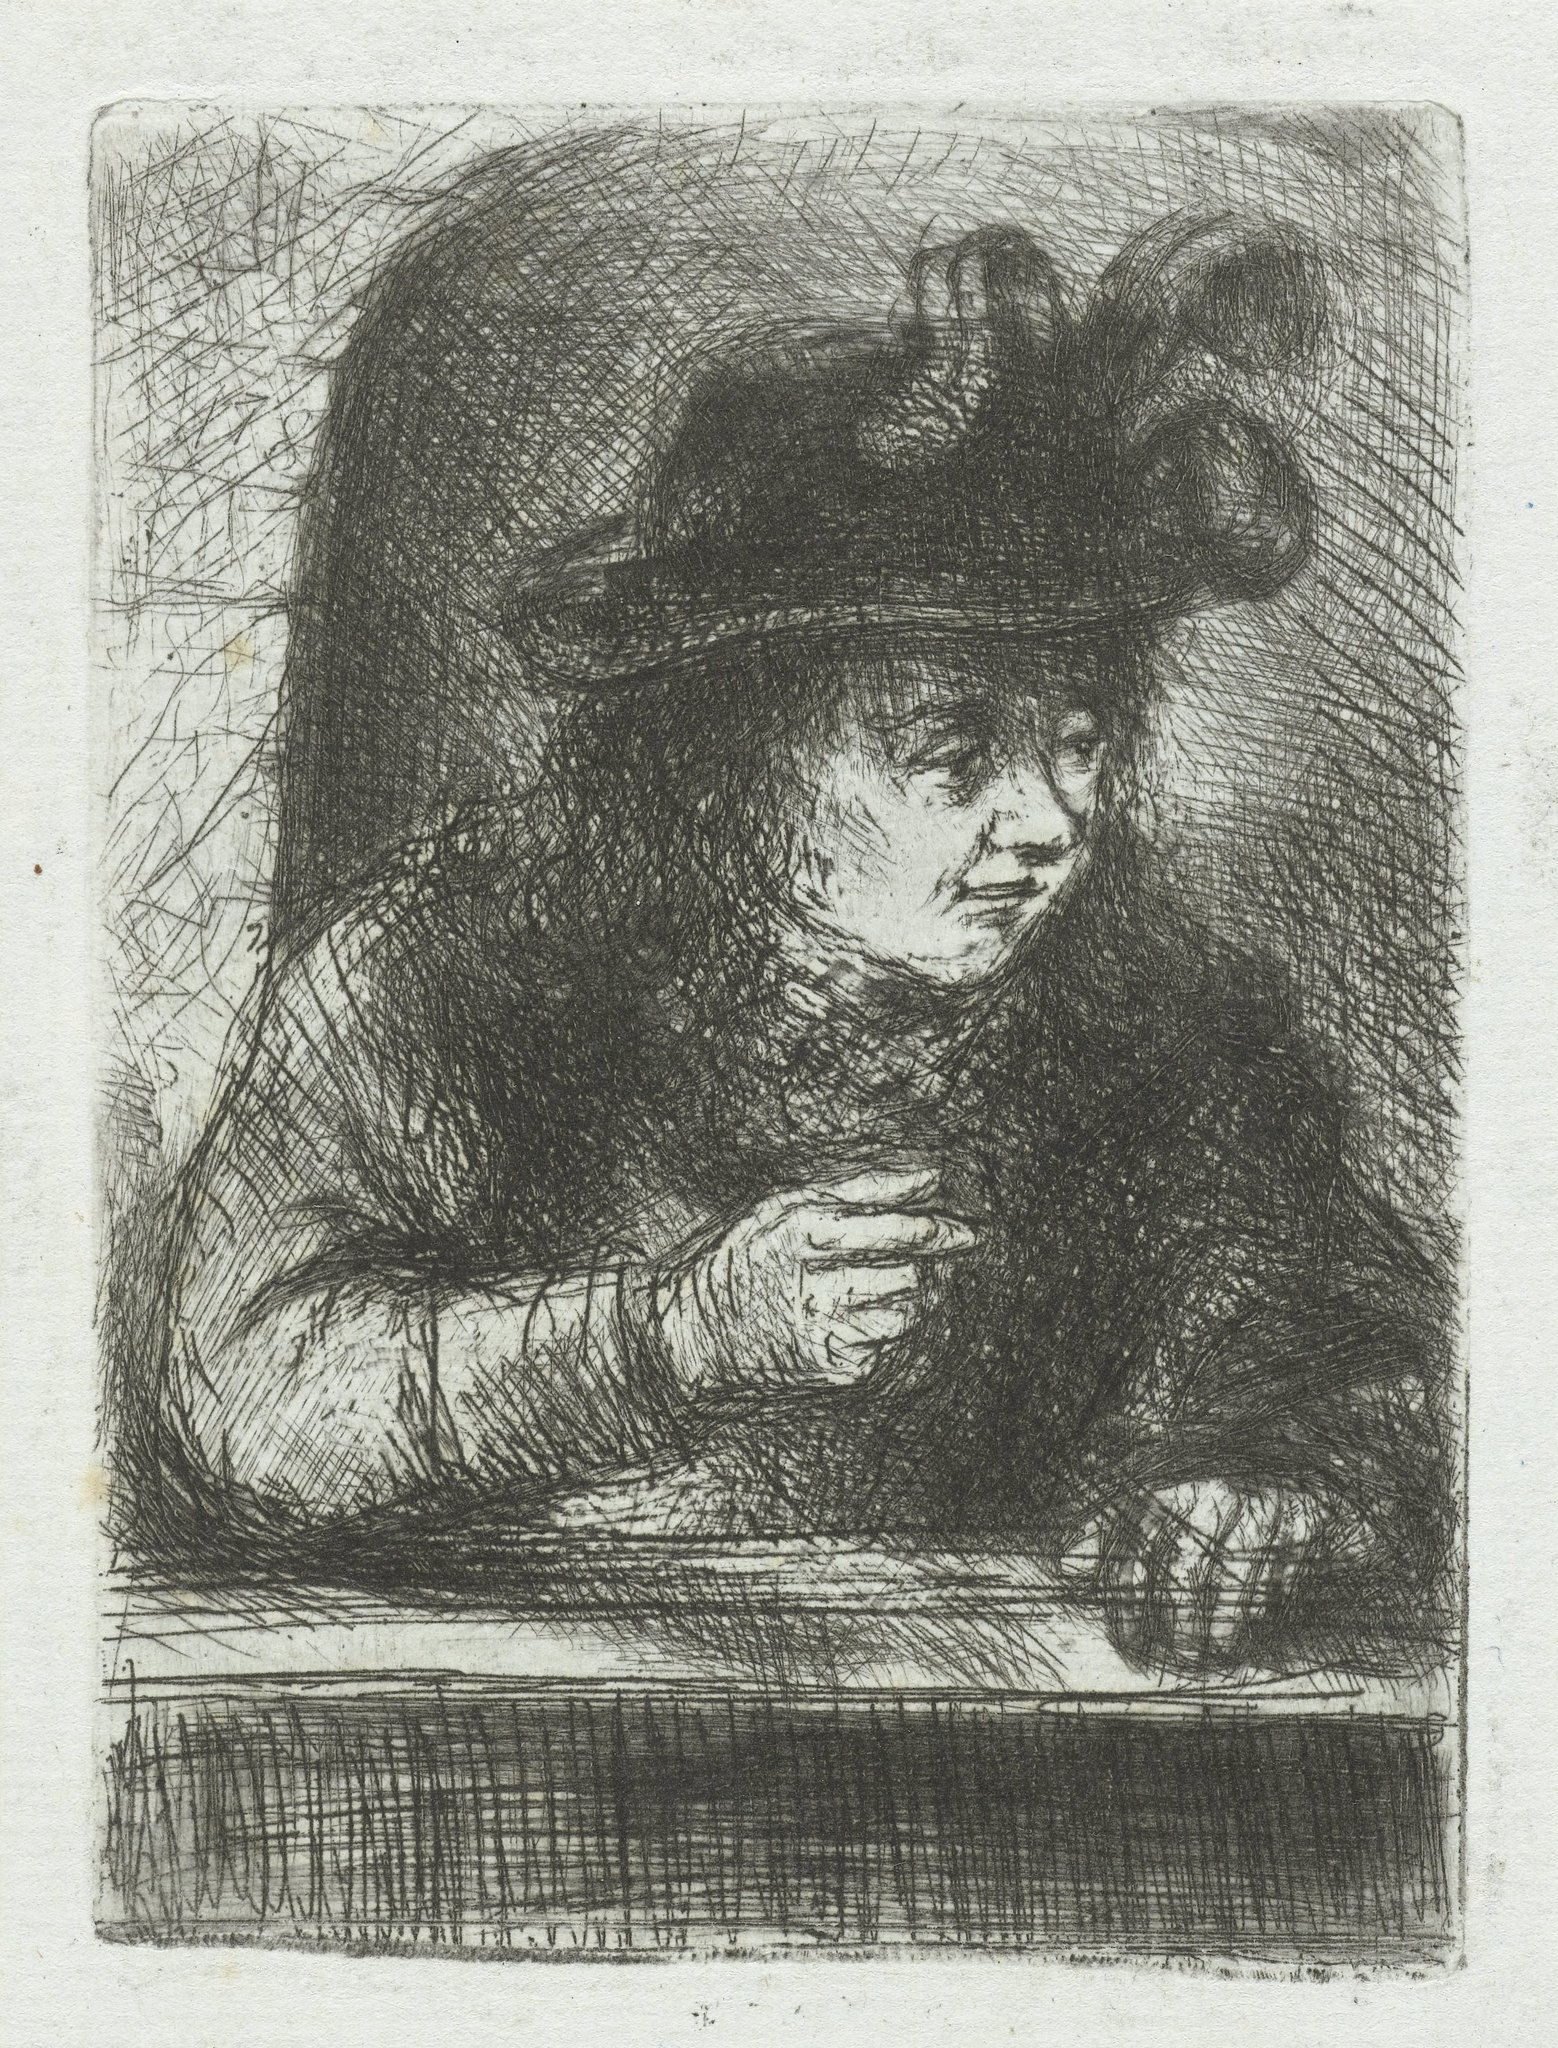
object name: print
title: Man bij balustrade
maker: jan chalon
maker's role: print maker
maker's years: 1738-1795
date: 1748-1795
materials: paper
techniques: drypoint, etching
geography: northern netherlands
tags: head-gear: hat (+ men's clothes), morphology of human expression (+ adult male (human being))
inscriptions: collector's mark: Lugt 924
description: Een volwassen man met hoed met veer staat naast een balustrade. Buste naar rechts.